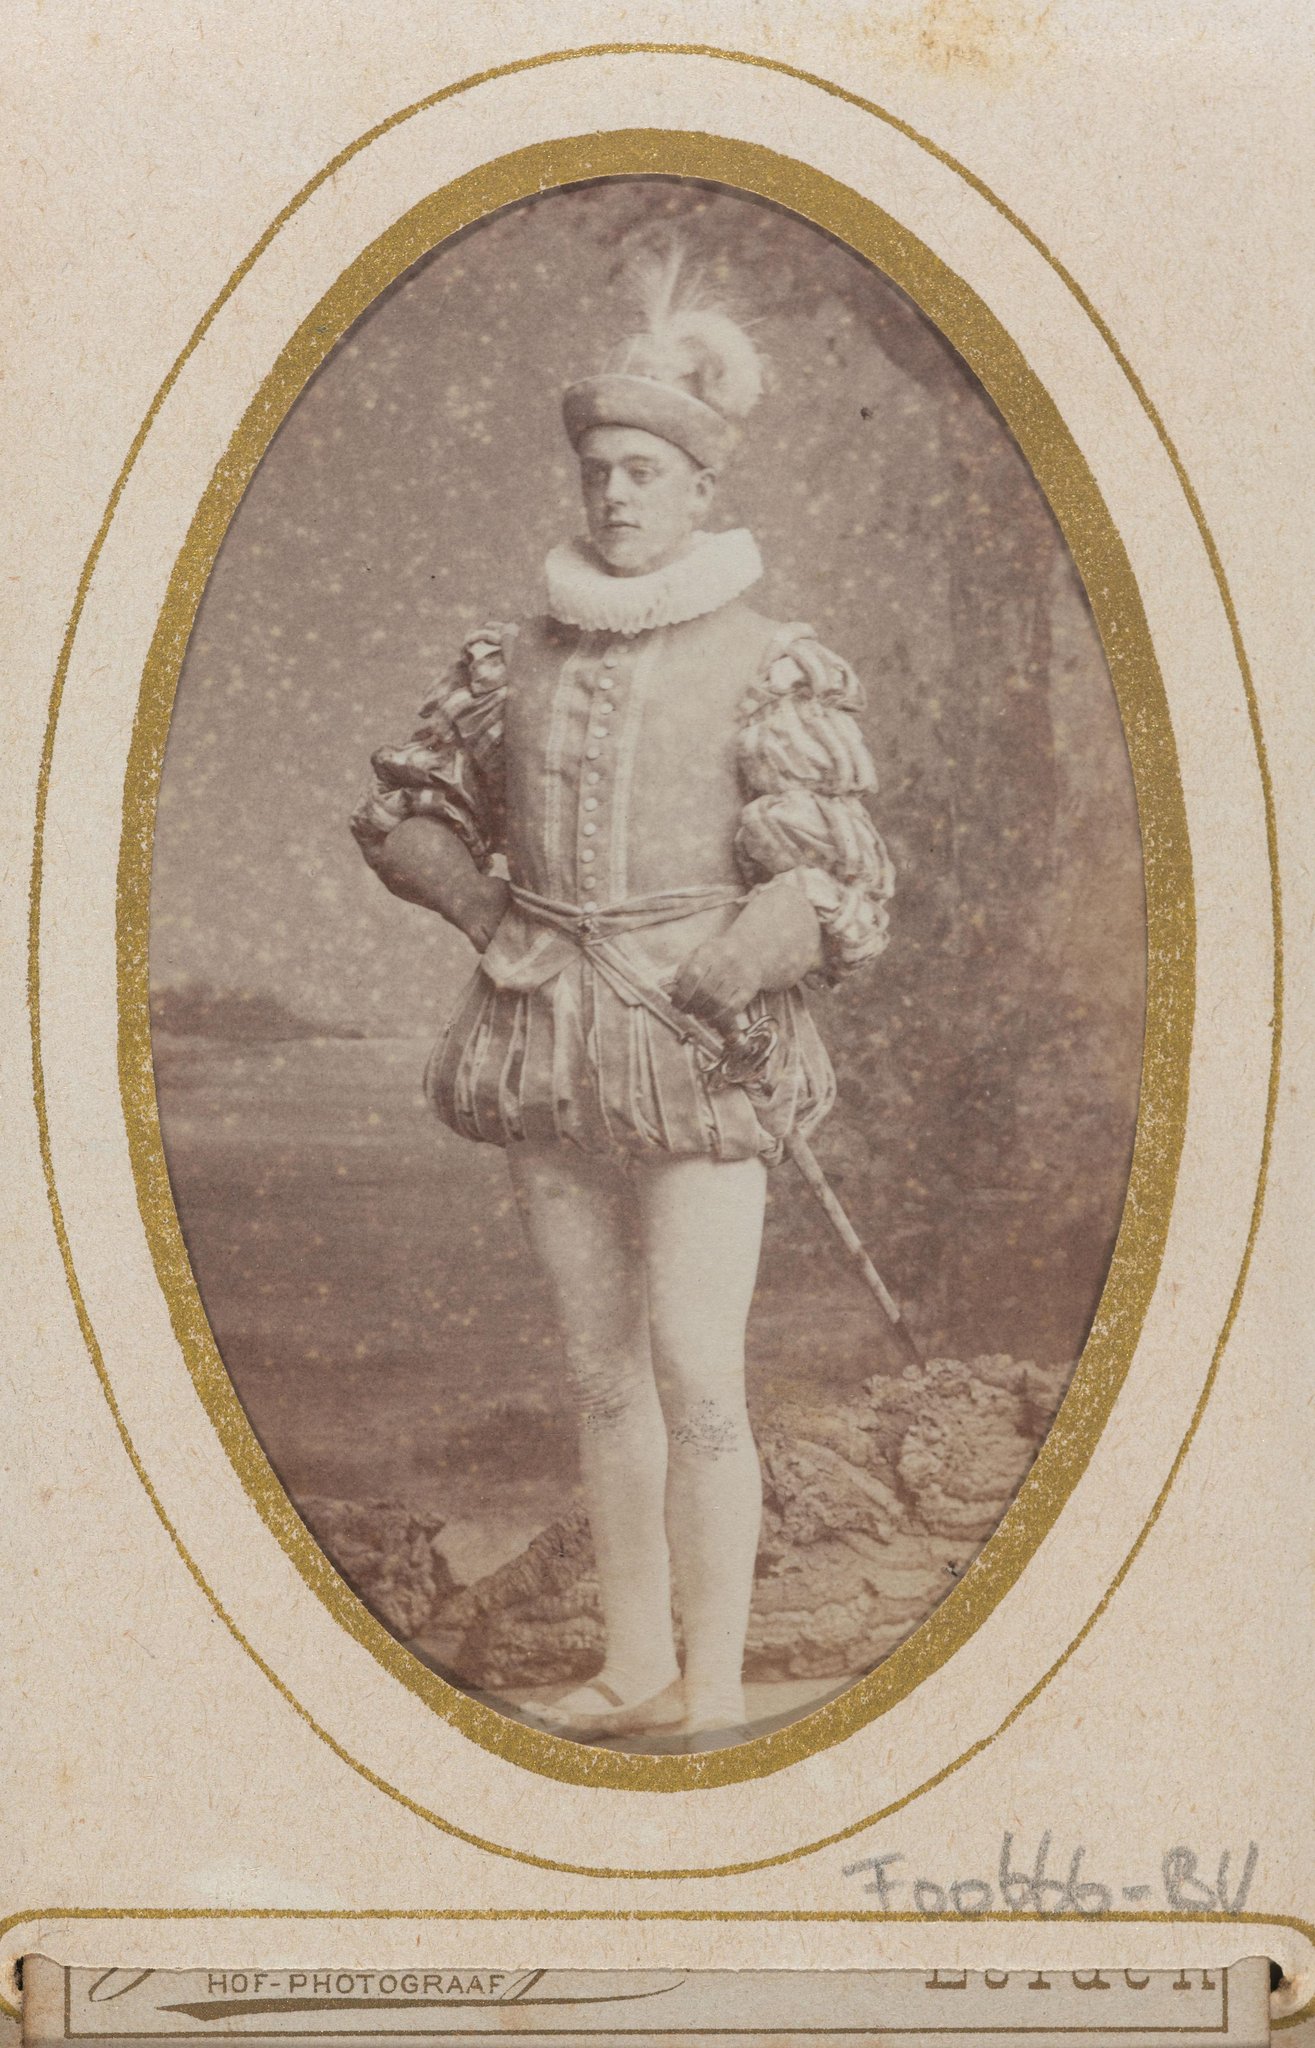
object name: album leaf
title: Portret van een jonge man in kostuum met degen, aangeduid als E.H. Winkelman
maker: jan goedeljee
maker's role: fotograaf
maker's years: 1824-1905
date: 1860-1905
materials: cardboard, photographic support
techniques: albumen print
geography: leiden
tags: historical persons, historical costume, hacking and thrusting weapons: rapier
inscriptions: inscription: ‘J. Goedeljee/ Photograaf/ Z. K. H. PRINS ALEXANDER/ der Nederlanden/ PRINS van ORANJE/ en H. K. H./ PRINSES HENDRIK/ der Nederlanden/ Hoogewoerd 160/ nabij de Plantage.’, name: ‘E. H. Winkelman./ 108’